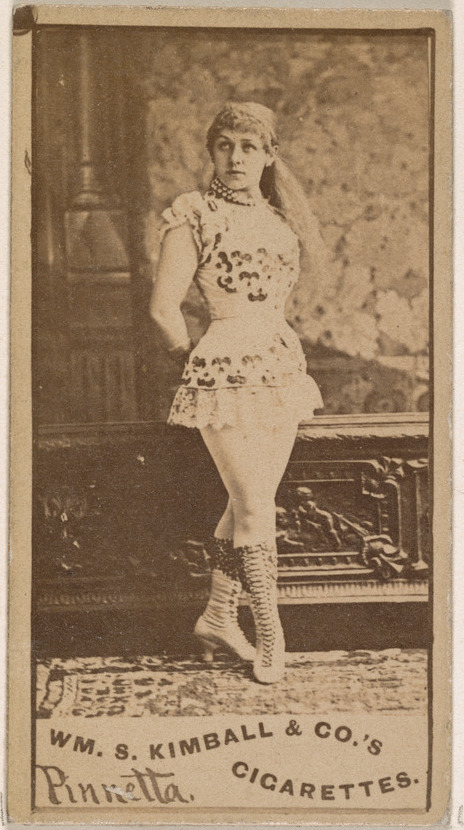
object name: photograph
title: Miss Pinnetta, from the Actresses series (N203) issued by Wm. S. Kimball & Co.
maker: william s. kimball & company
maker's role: publisher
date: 1889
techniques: color lithograph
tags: portraits,women,actresses